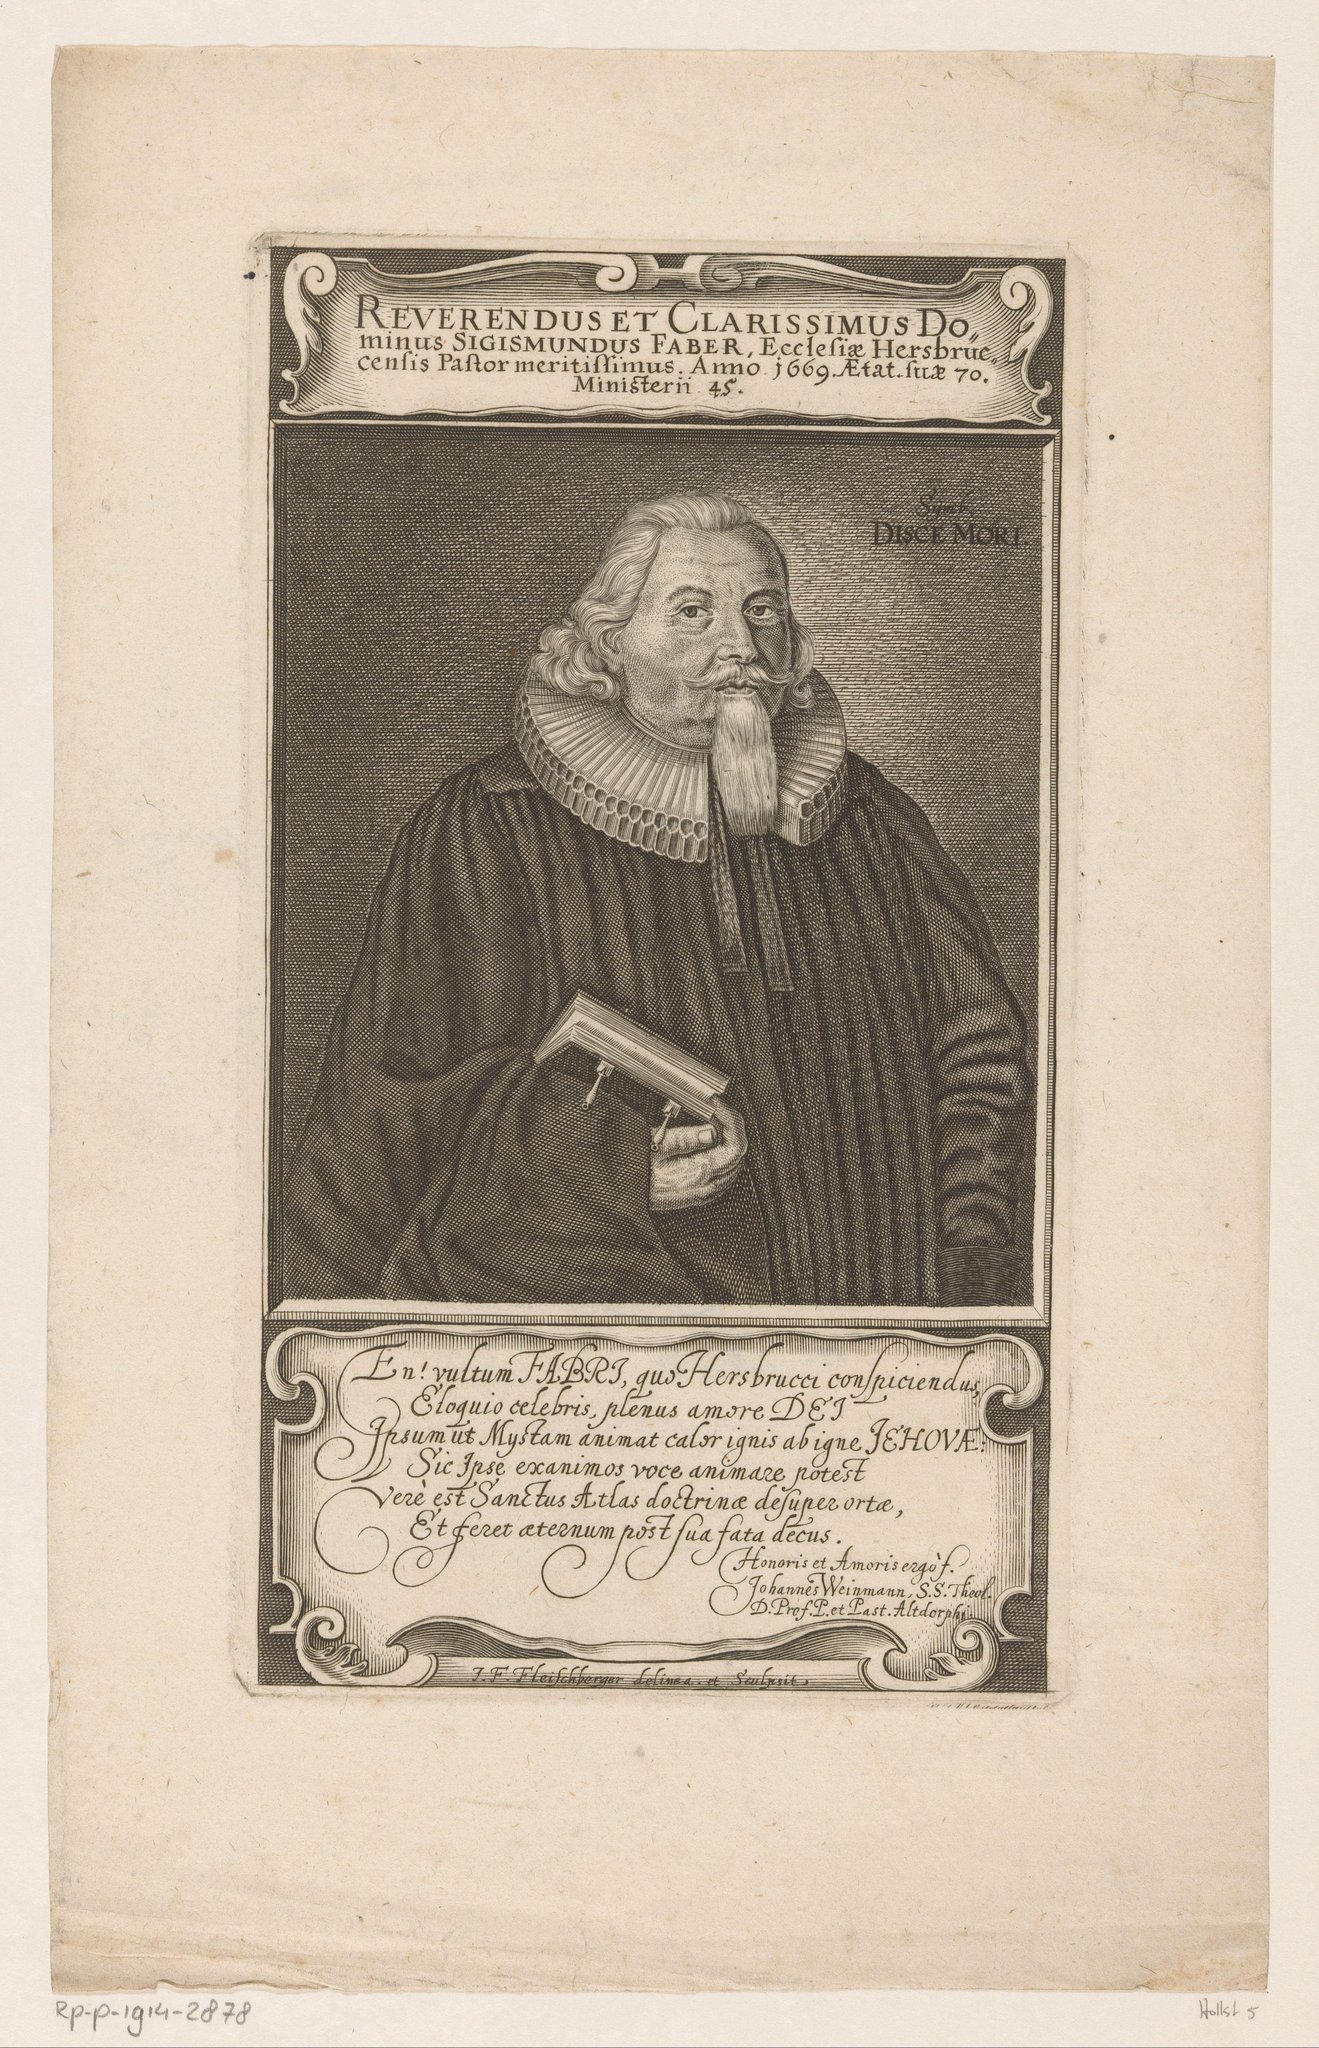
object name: print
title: Portret van Sigismund Faber op 70-jarige leeftijd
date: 1641-1665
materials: paper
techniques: engraving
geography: nuremberg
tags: historical persons, book, ornament ~ cartouche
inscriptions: collector's mark: Lugt 2228